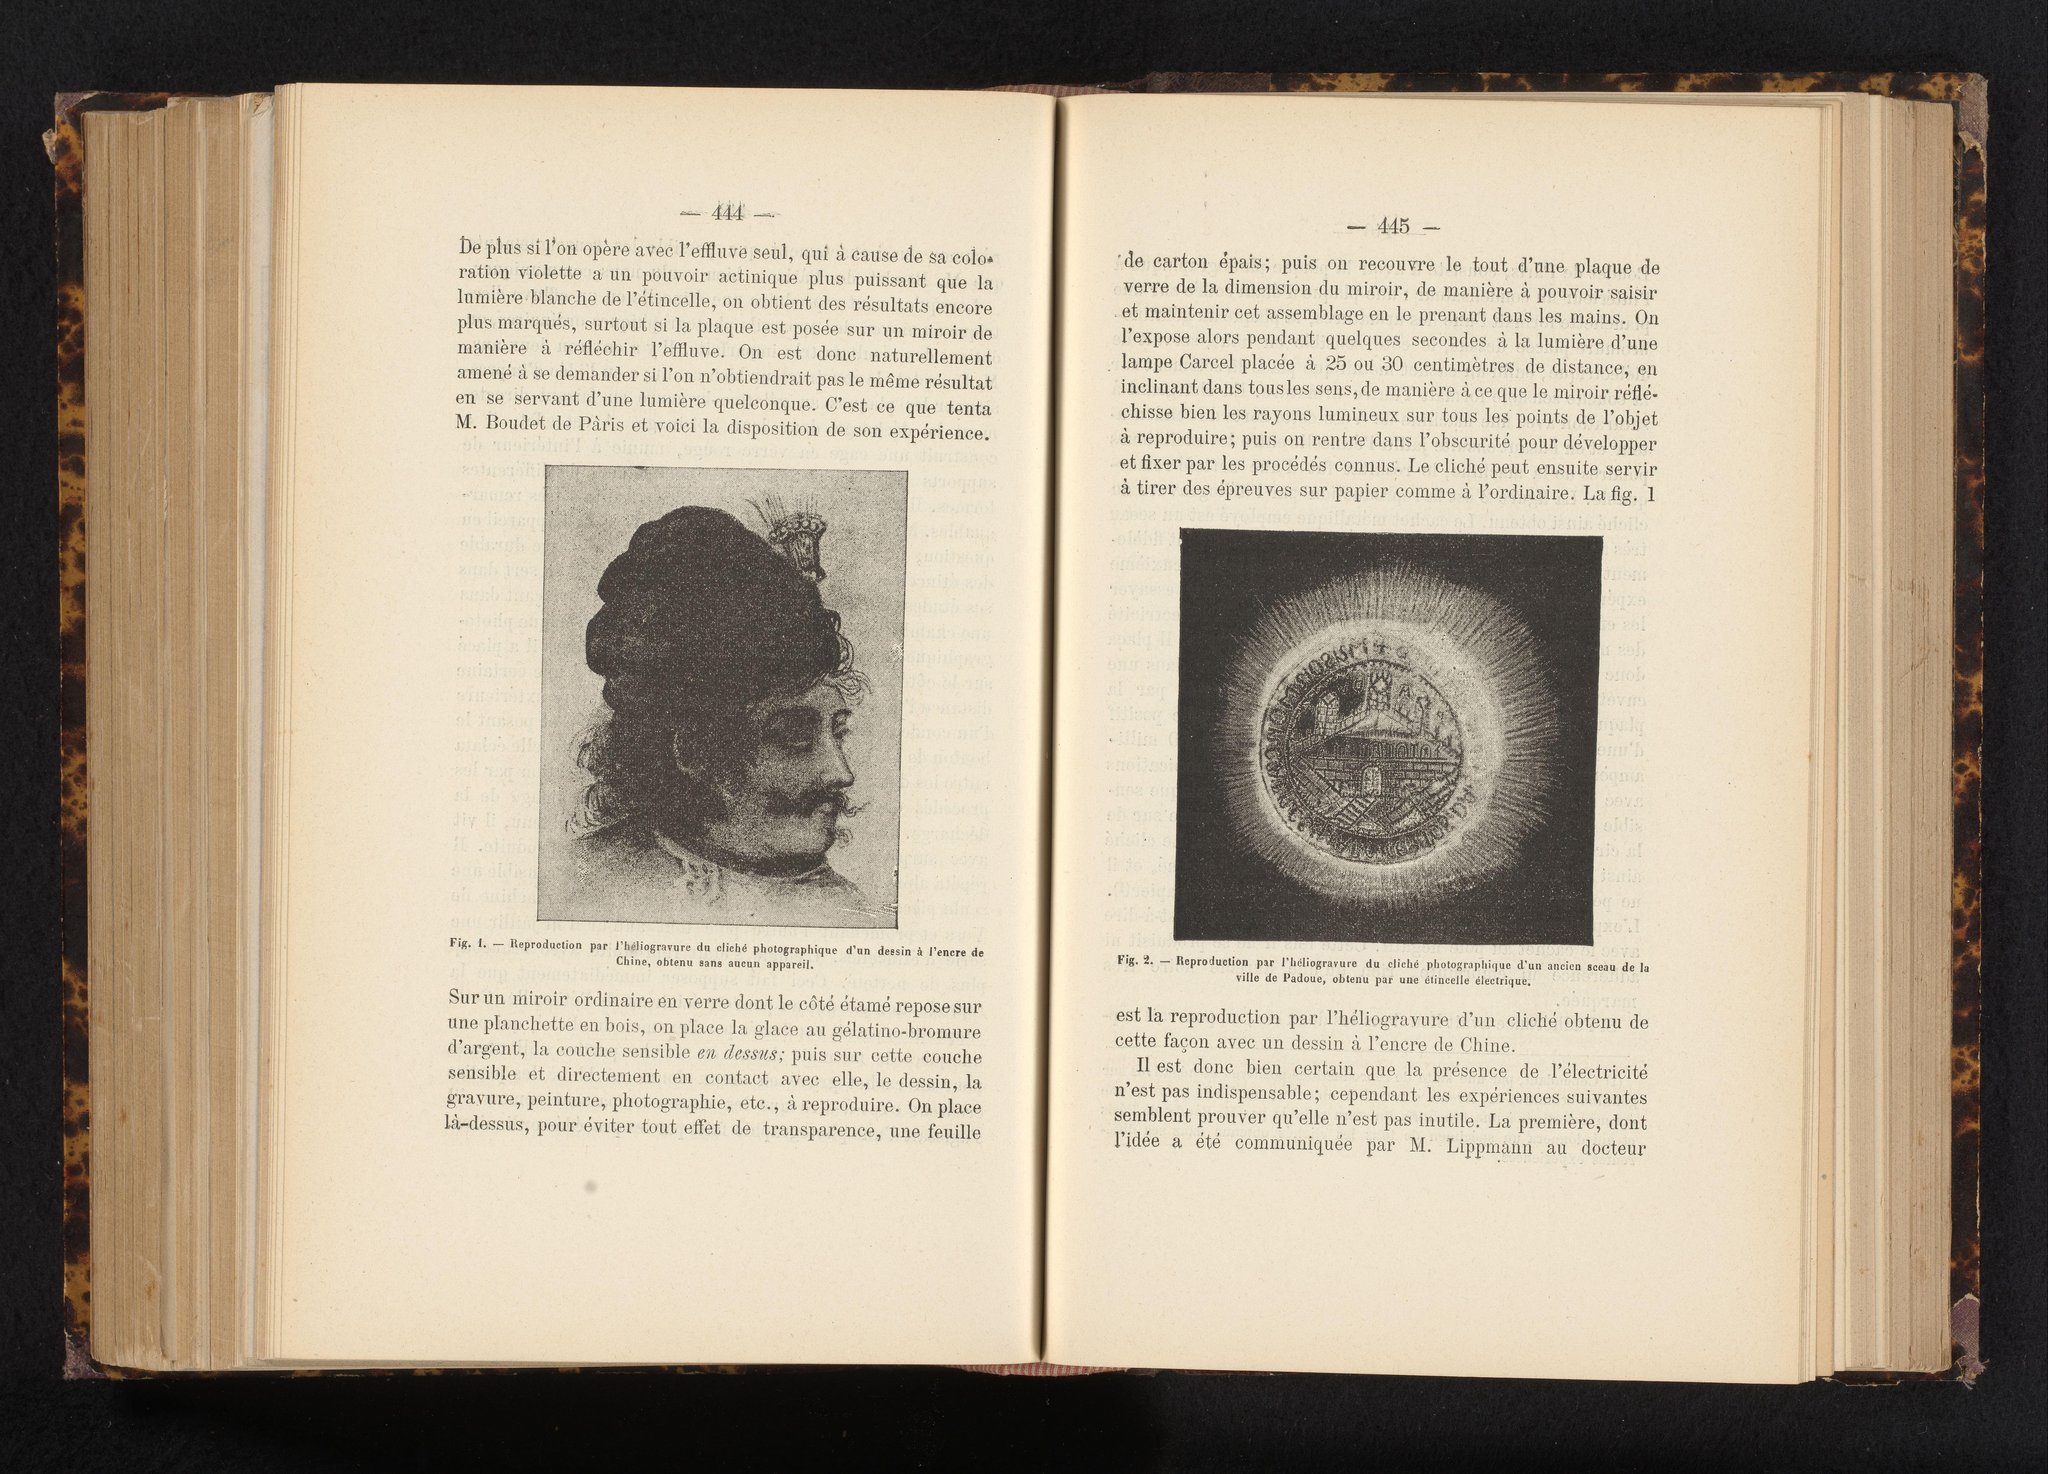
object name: page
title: Munt met halo van elektrische stroom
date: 1881-1886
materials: paper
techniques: autotype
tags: electrical phenomena, coin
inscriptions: inscription: ‘Fig. 2.- Reproduction par l'héliogravure du cliché photographique d'un ancien sceau de la/ ville de Padoue, obtenu par ine étincelle électrique.’